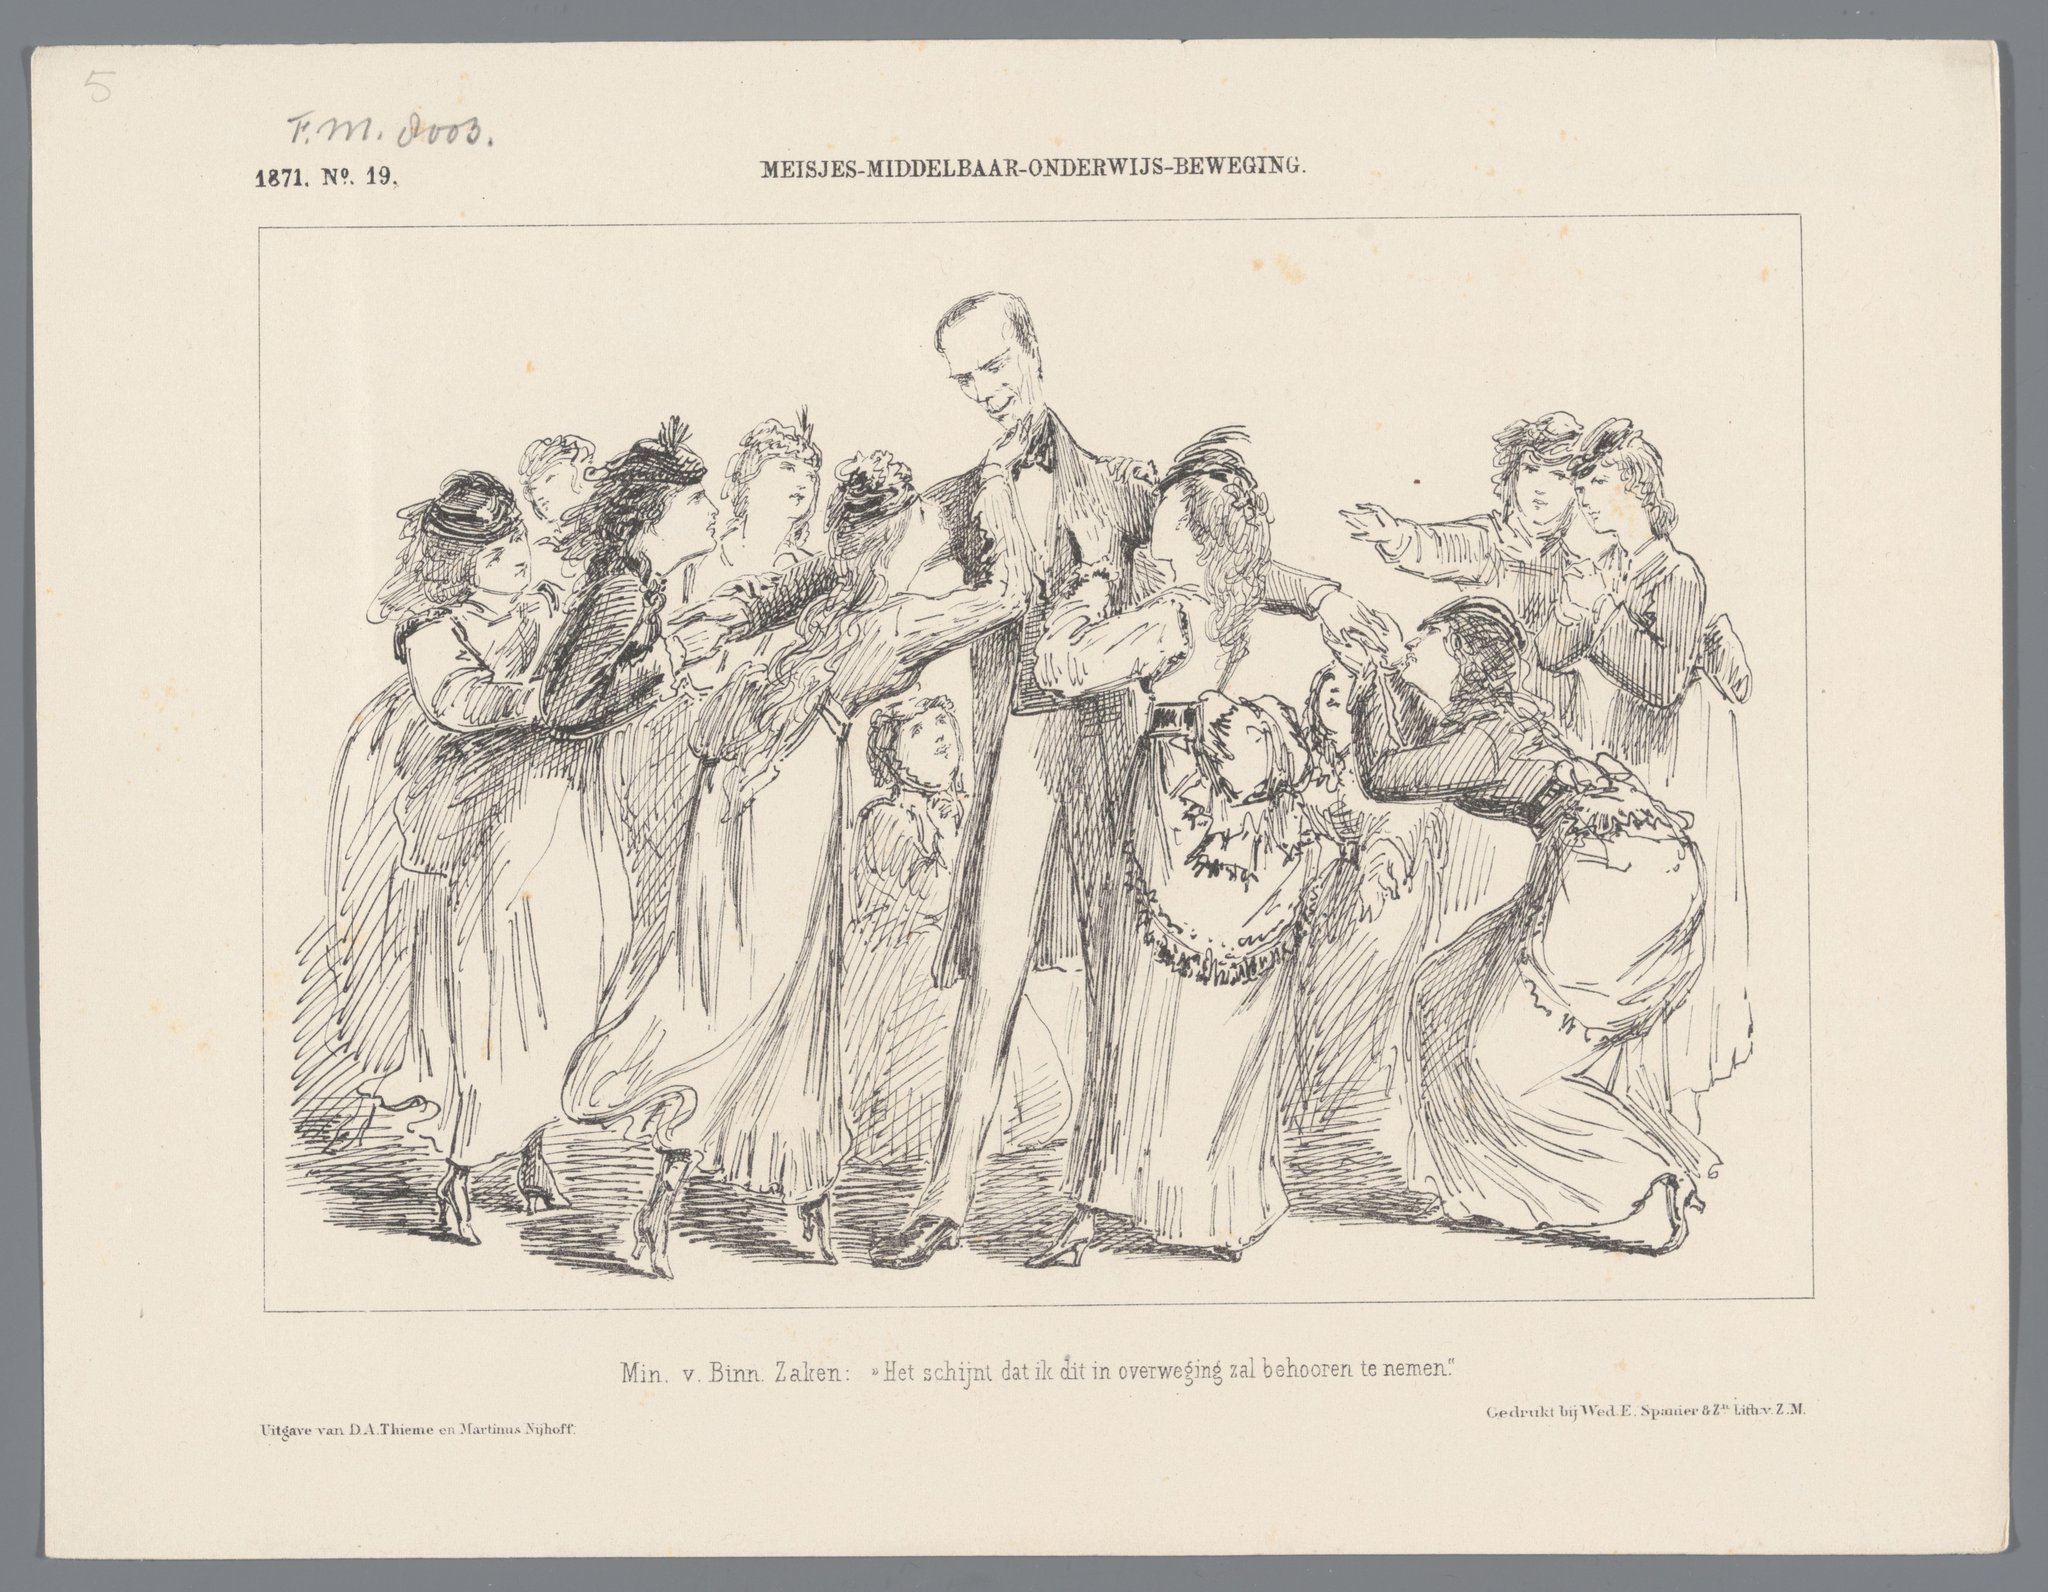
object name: print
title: Meisjes-middelbaar-onderwijs-beweging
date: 1871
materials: paper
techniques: lithograph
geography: netherlands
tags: the hague, johan rudolf thorbecke, secondary education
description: Spotprent waarin Minister van Binnenlandse Zaken Thorbecke door jonge dames wordt bestormd met smeekbeden voor middelbaar onderwijs voor meisjes. Plaat verschenen bij het weekblad De Nederlandsche Spectator, nr. 19, 1871.